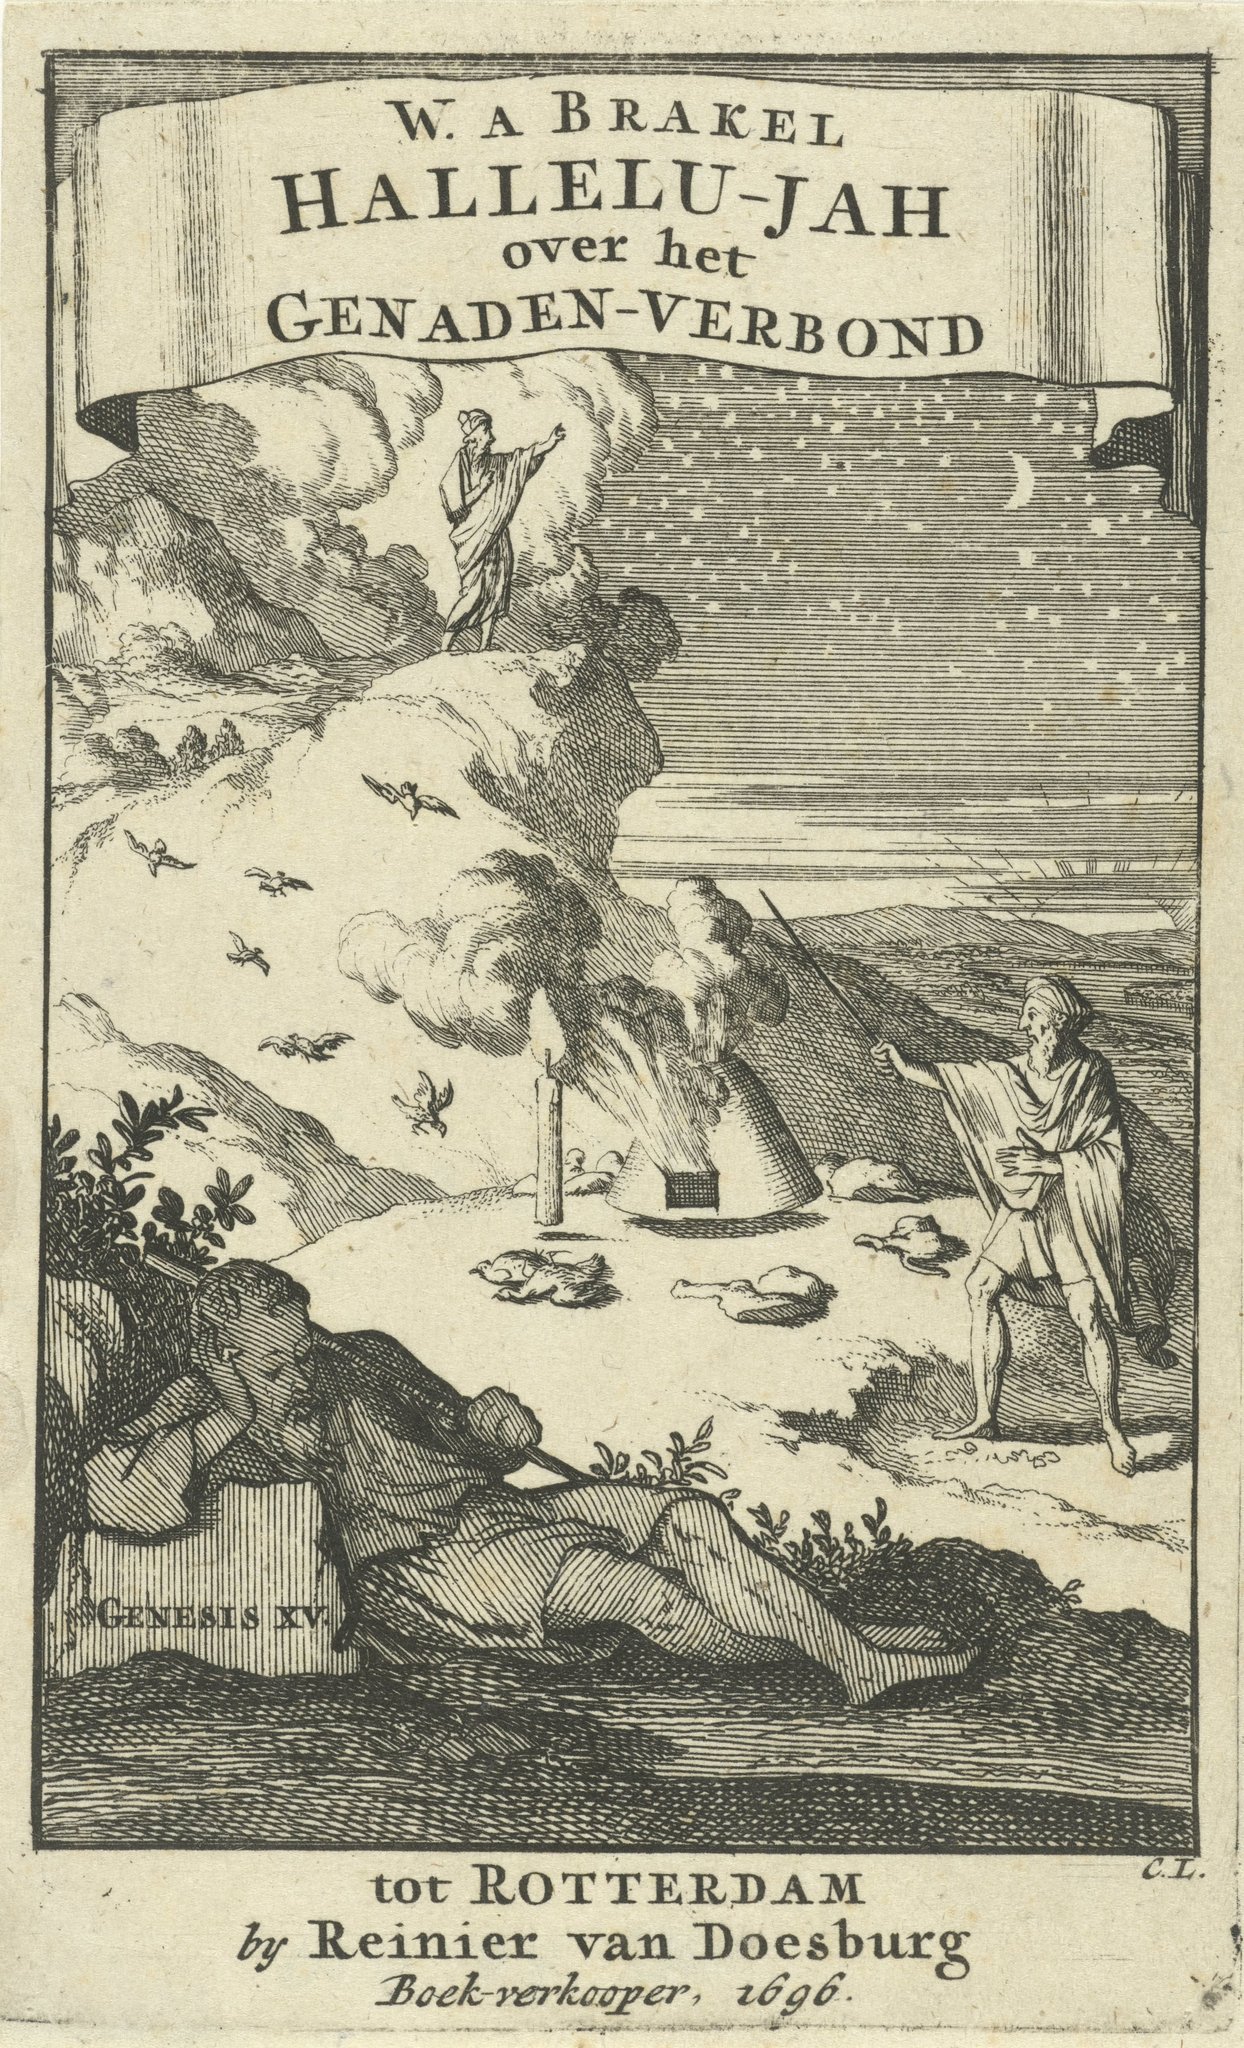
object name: print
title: Titelpagina voor: W. à Brakel, Hallelu-jah, ofte Lof des Heeren, over het genaden-verbondt, ende des selfs bedieninge in het Oude en N. Testament, 1696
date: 1696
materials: paper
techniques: etching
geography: amsterdam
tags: god's covenant with abraham (genesis 15), abraham counting the stars, abraham chases away the birds that come down on the carcasses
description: Titelpagina voor: Brakel, Wilhelmus à. Hallelu-jah, ofte Lof des Heeren, over het genaden-verbondt, ende des selfs bedieninge in het Oude en N. Testament. Rotterdam: Reinier van Doesburg, 1696.